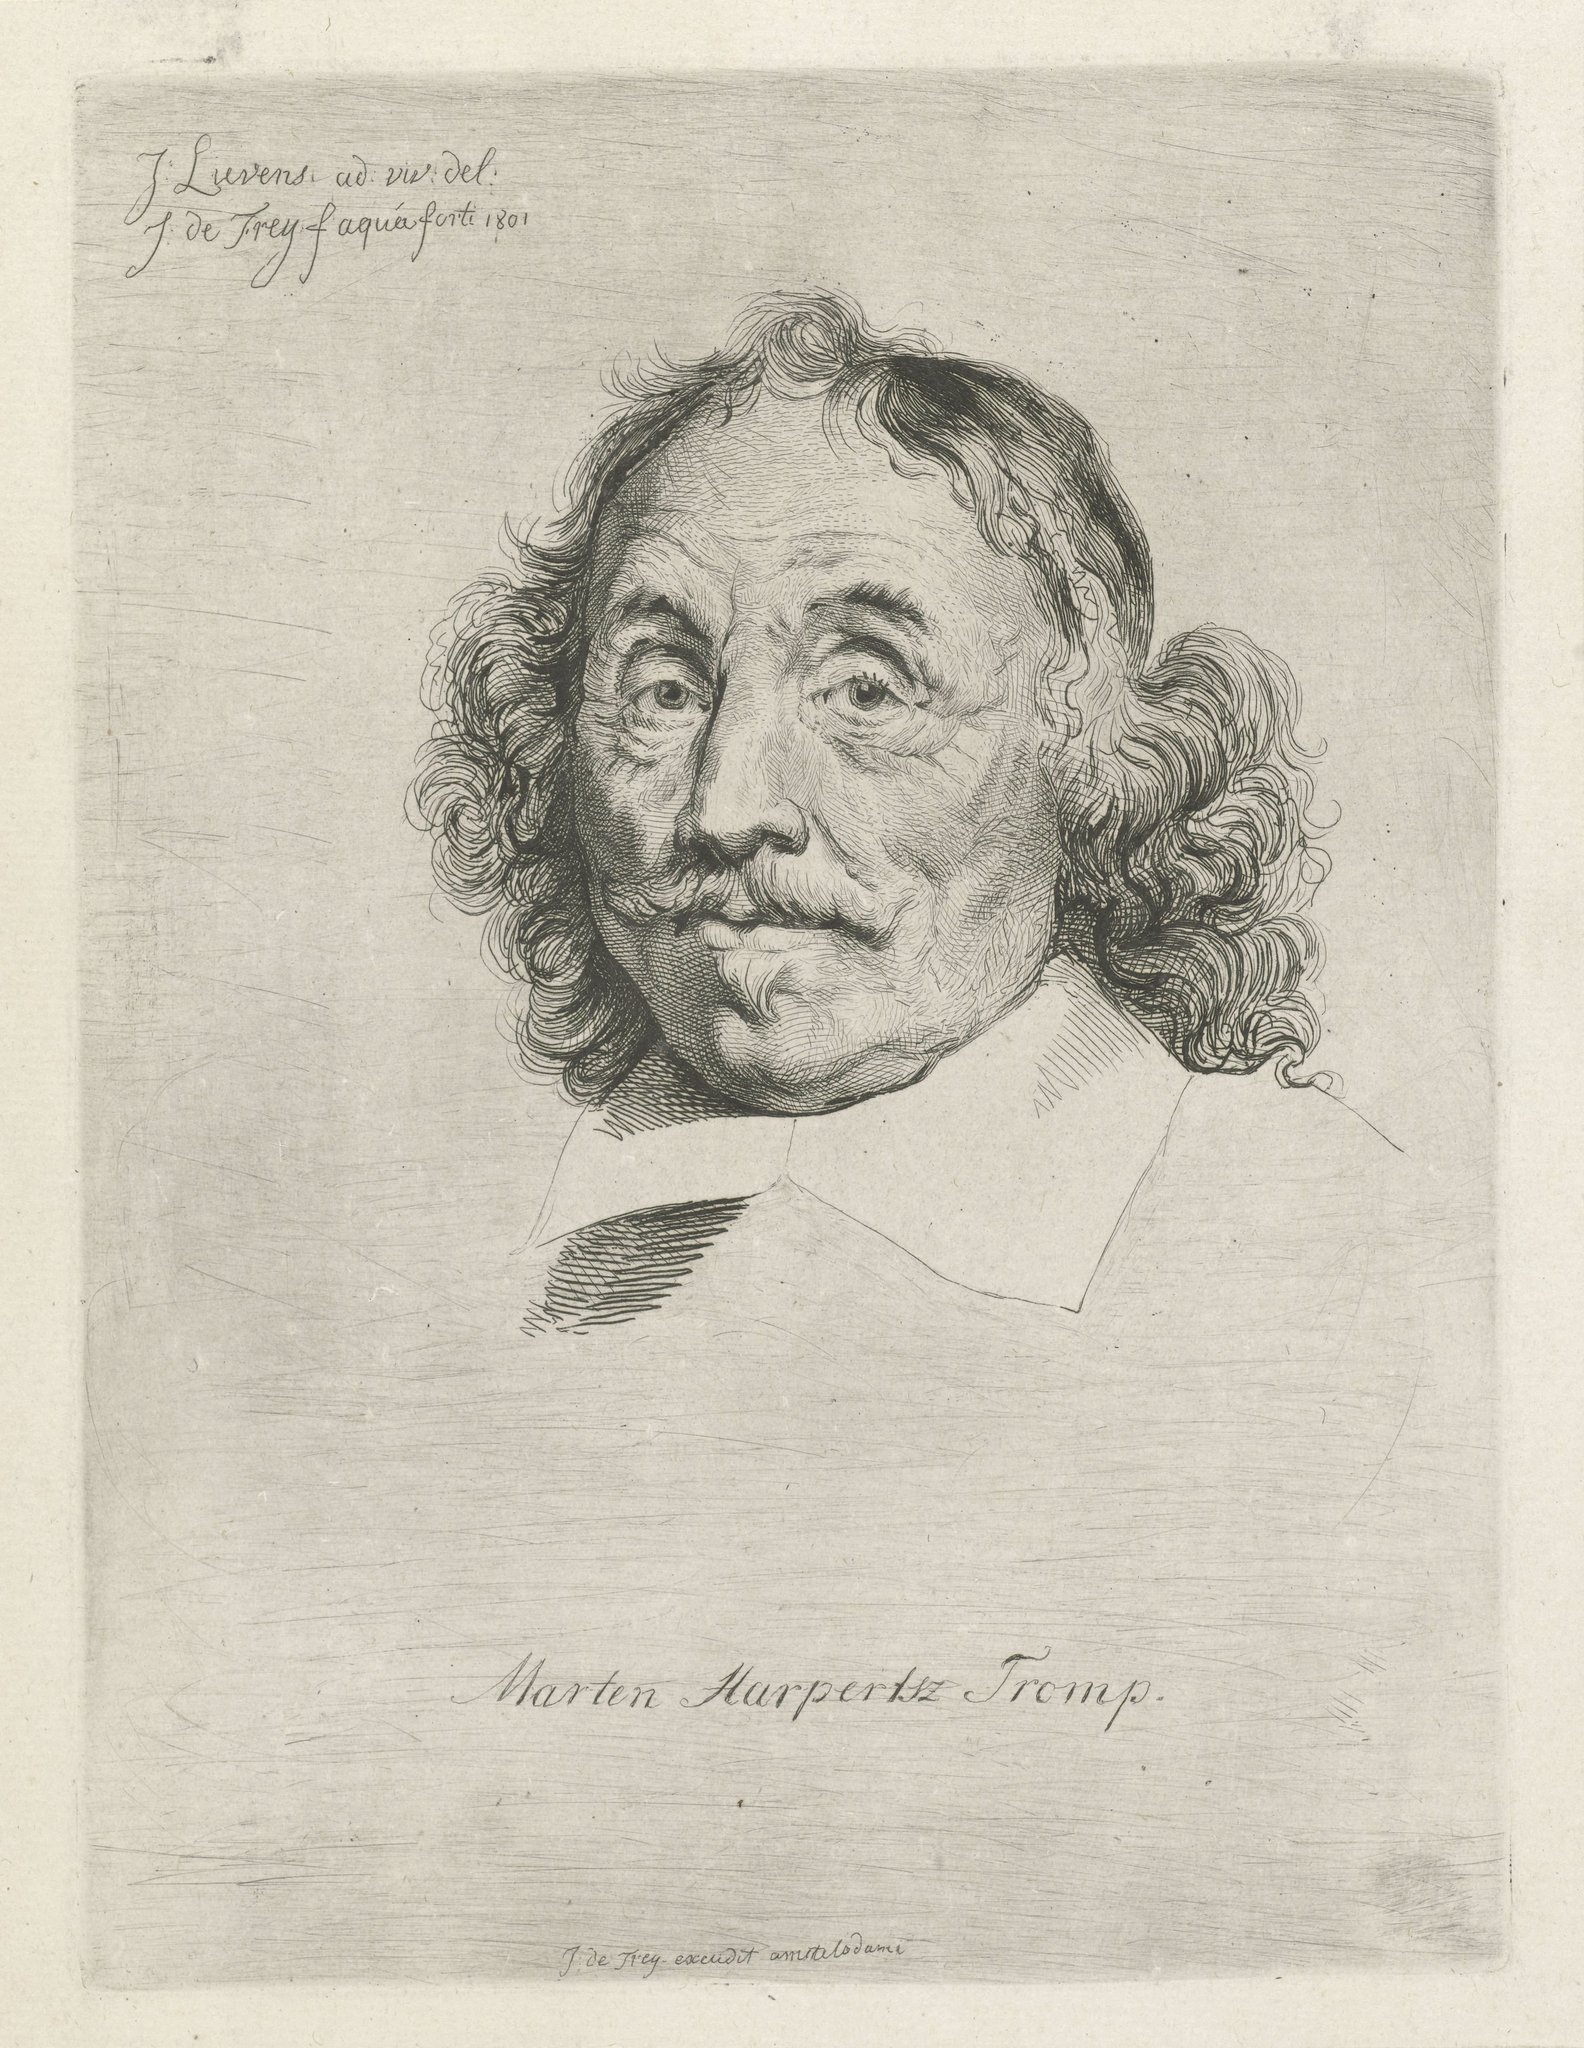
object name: print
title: Marten Harpertsz Tromp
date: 1801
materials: paper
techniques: etching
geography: amsterdam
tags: maarten harpertszoon tromp, historical persons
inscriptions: collector's mark: Lugt 2228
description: Portret van admiraal Maarten Harpertszoon Tromp waarbij alleen het hoofd in detail is uitgewerkt. Portretbuste en face, iets naar links.